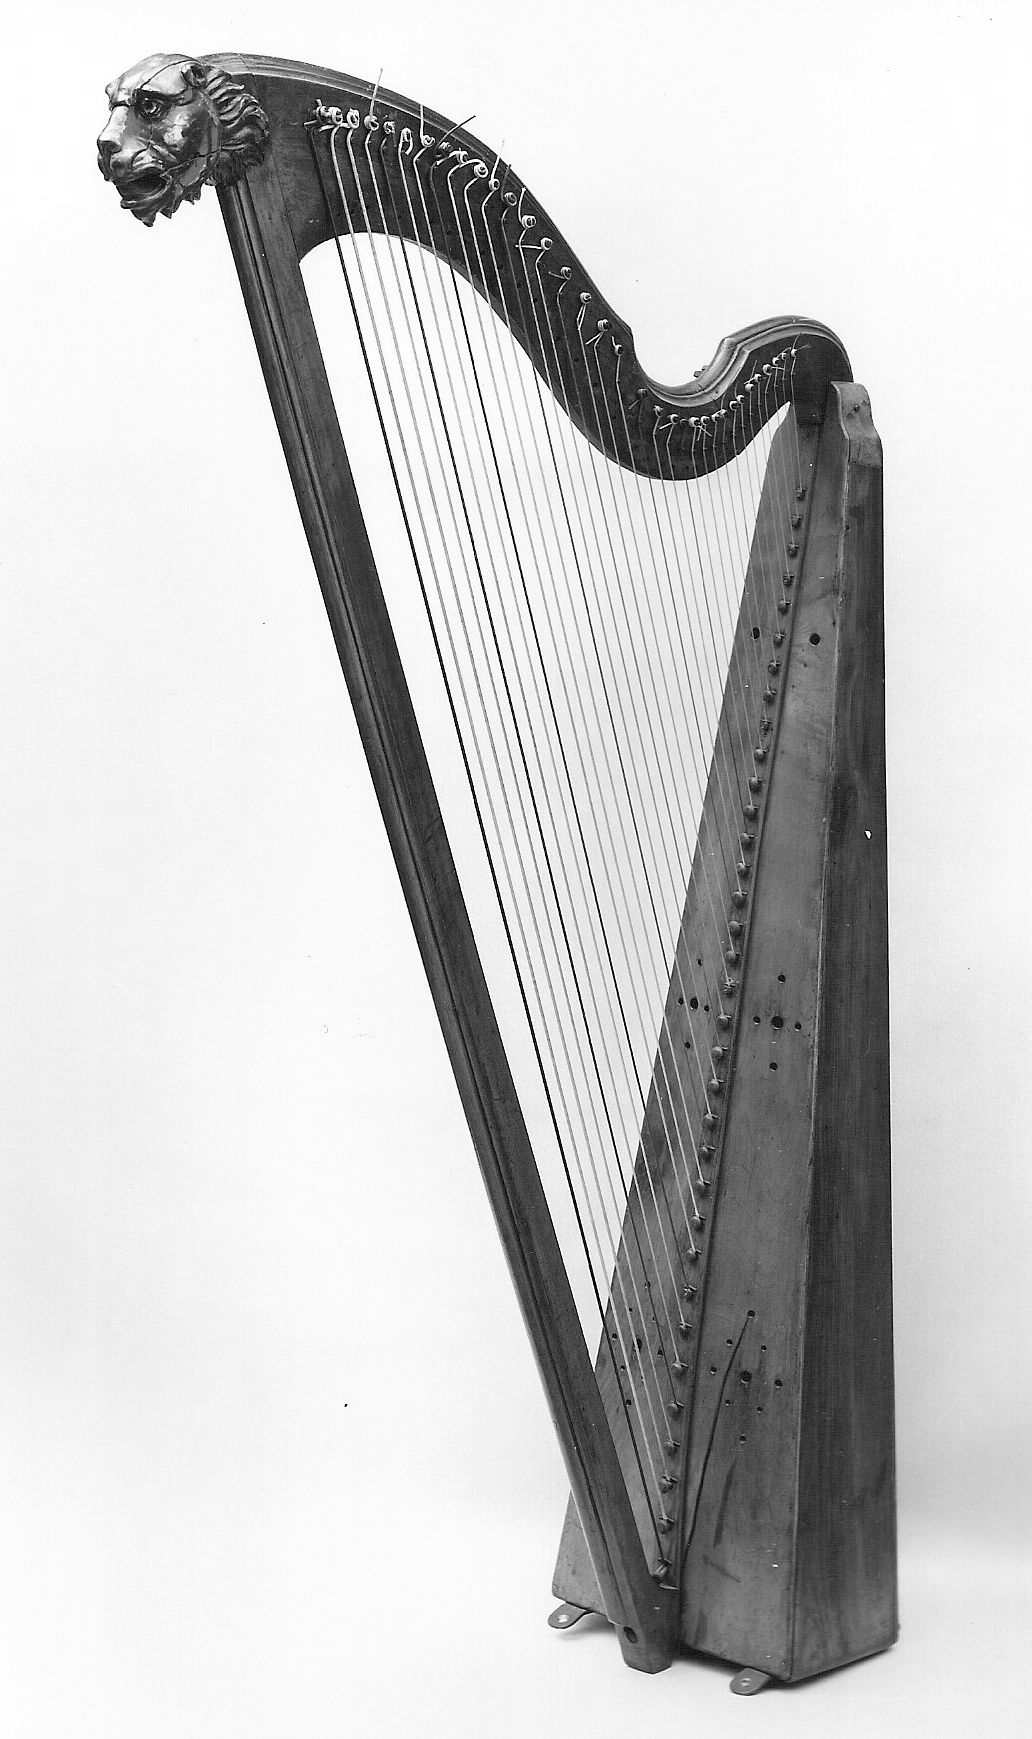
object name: harp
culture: italian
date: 1701-1800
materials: wood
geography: italy